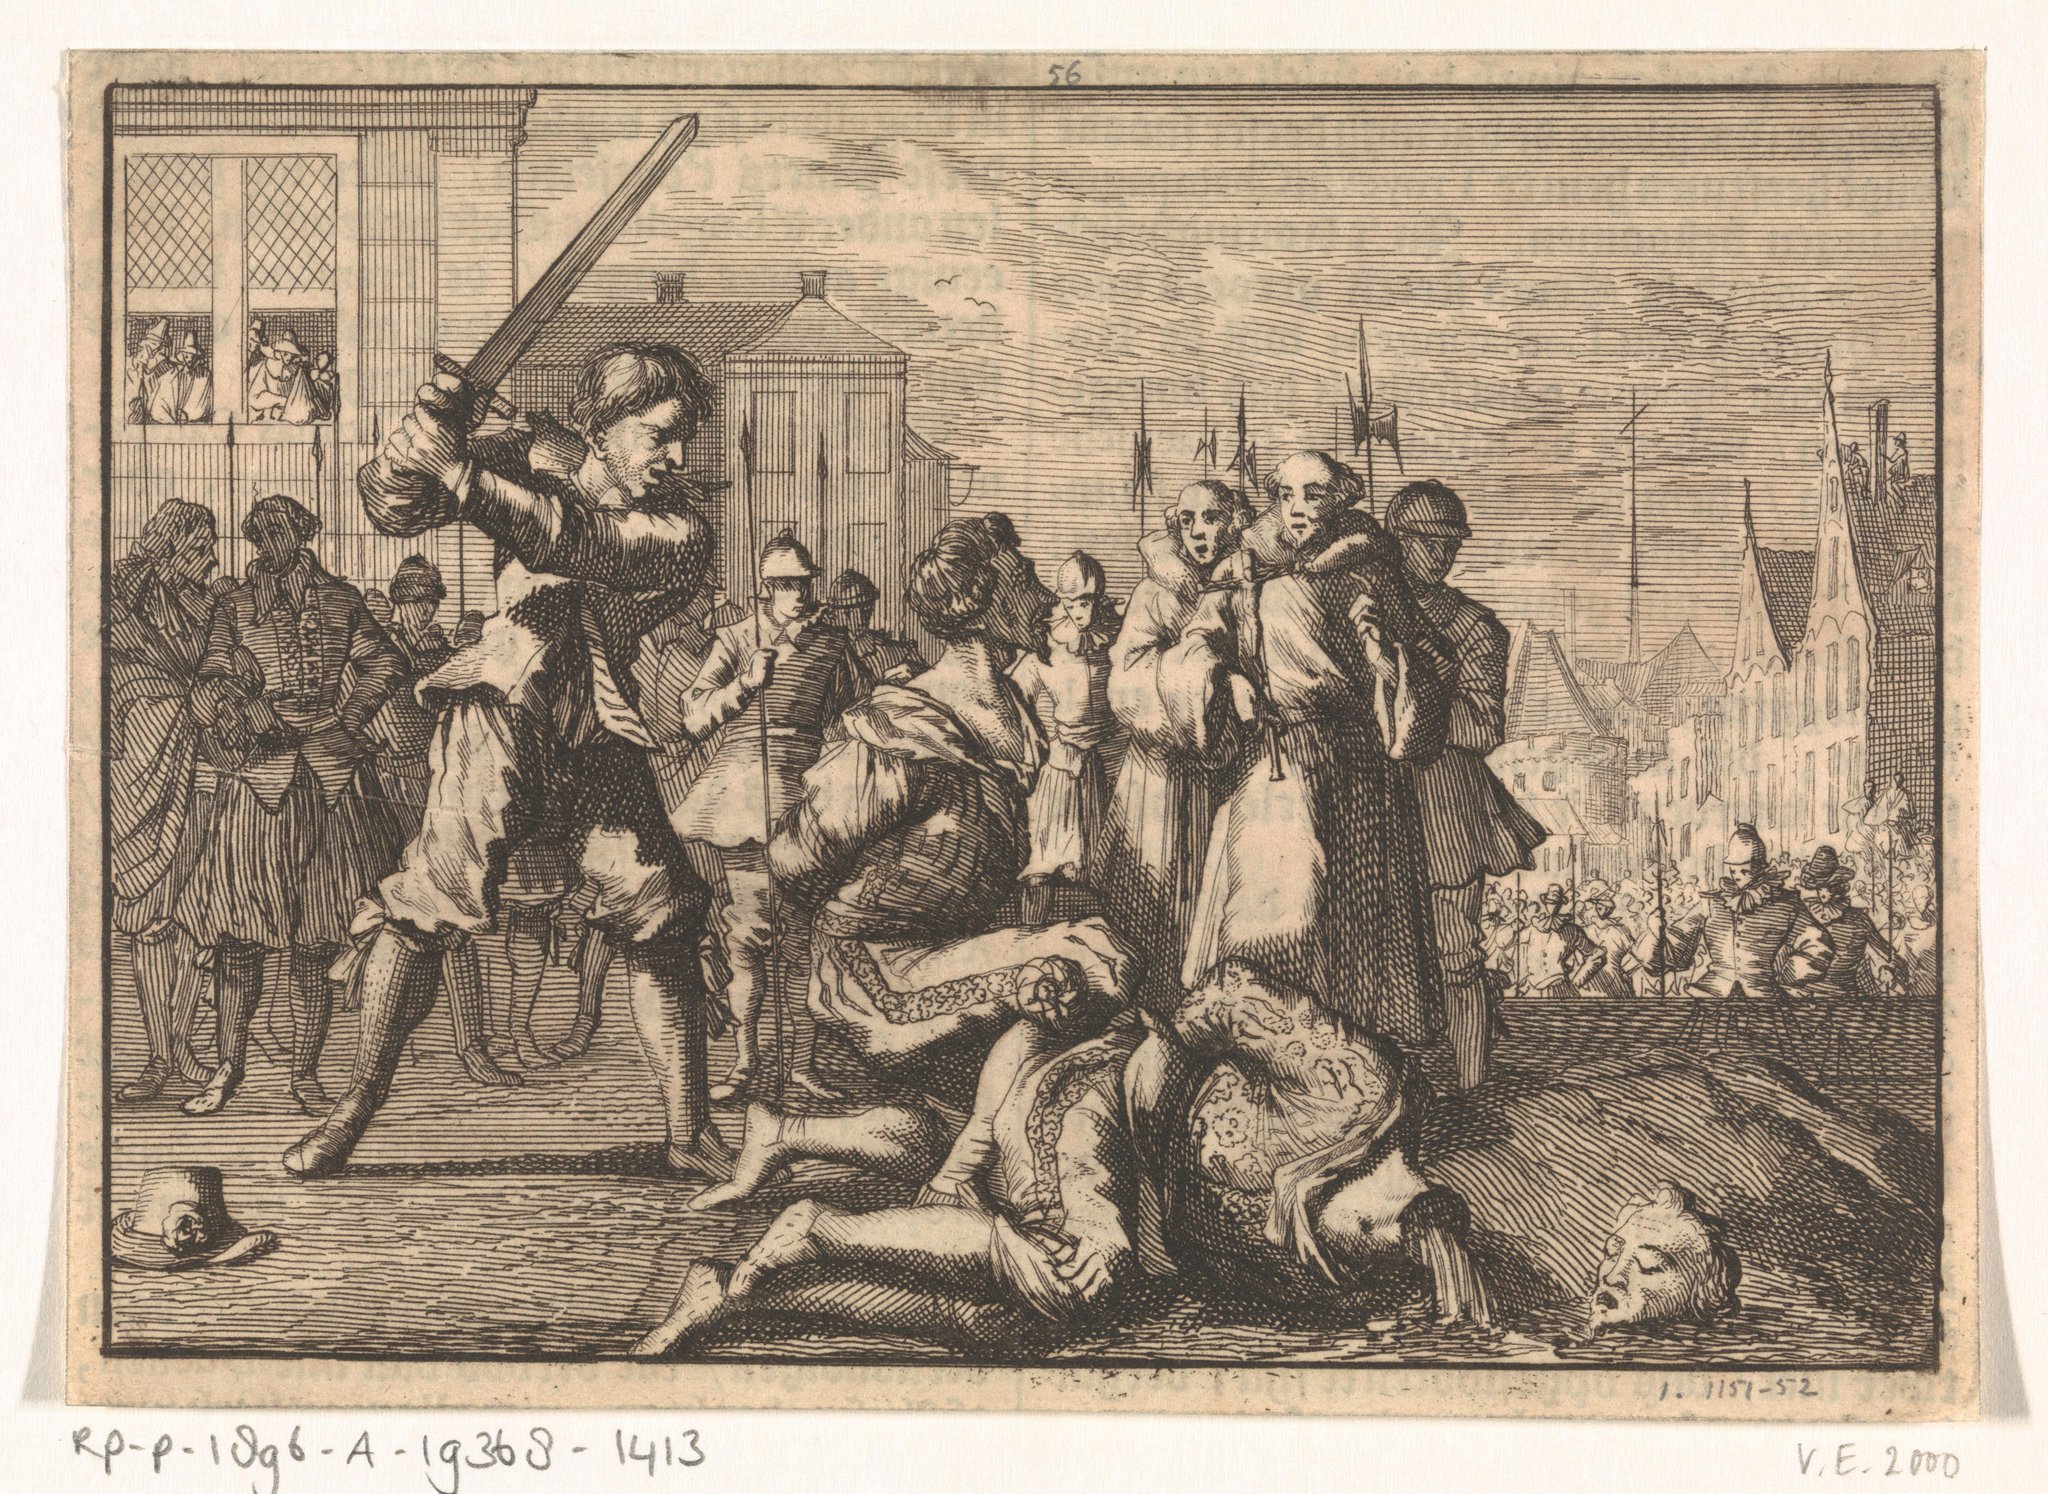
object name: book illustration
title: Beruchte duellisten De Bouteville en de graaf van Chapelle worden te Parijs onthoofd, 1627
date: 1698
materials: paper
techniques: etching, letterpress printing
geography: amsterdam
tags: paris, violent death by beheading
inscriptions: collector's mark: Lugt 2228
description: Illustratie uit: Gottfried, Johann Ludwig. Historische kronyck; vervattende een (...) beschrijvingh der aldergedenckwaerdigste geschiedenissen des weerelds, van den aenvangh der scheppingh tot (...) 1576 (2 delen). Leiden: Pieter van der Aa, 1698, dl. I, p. 1151.